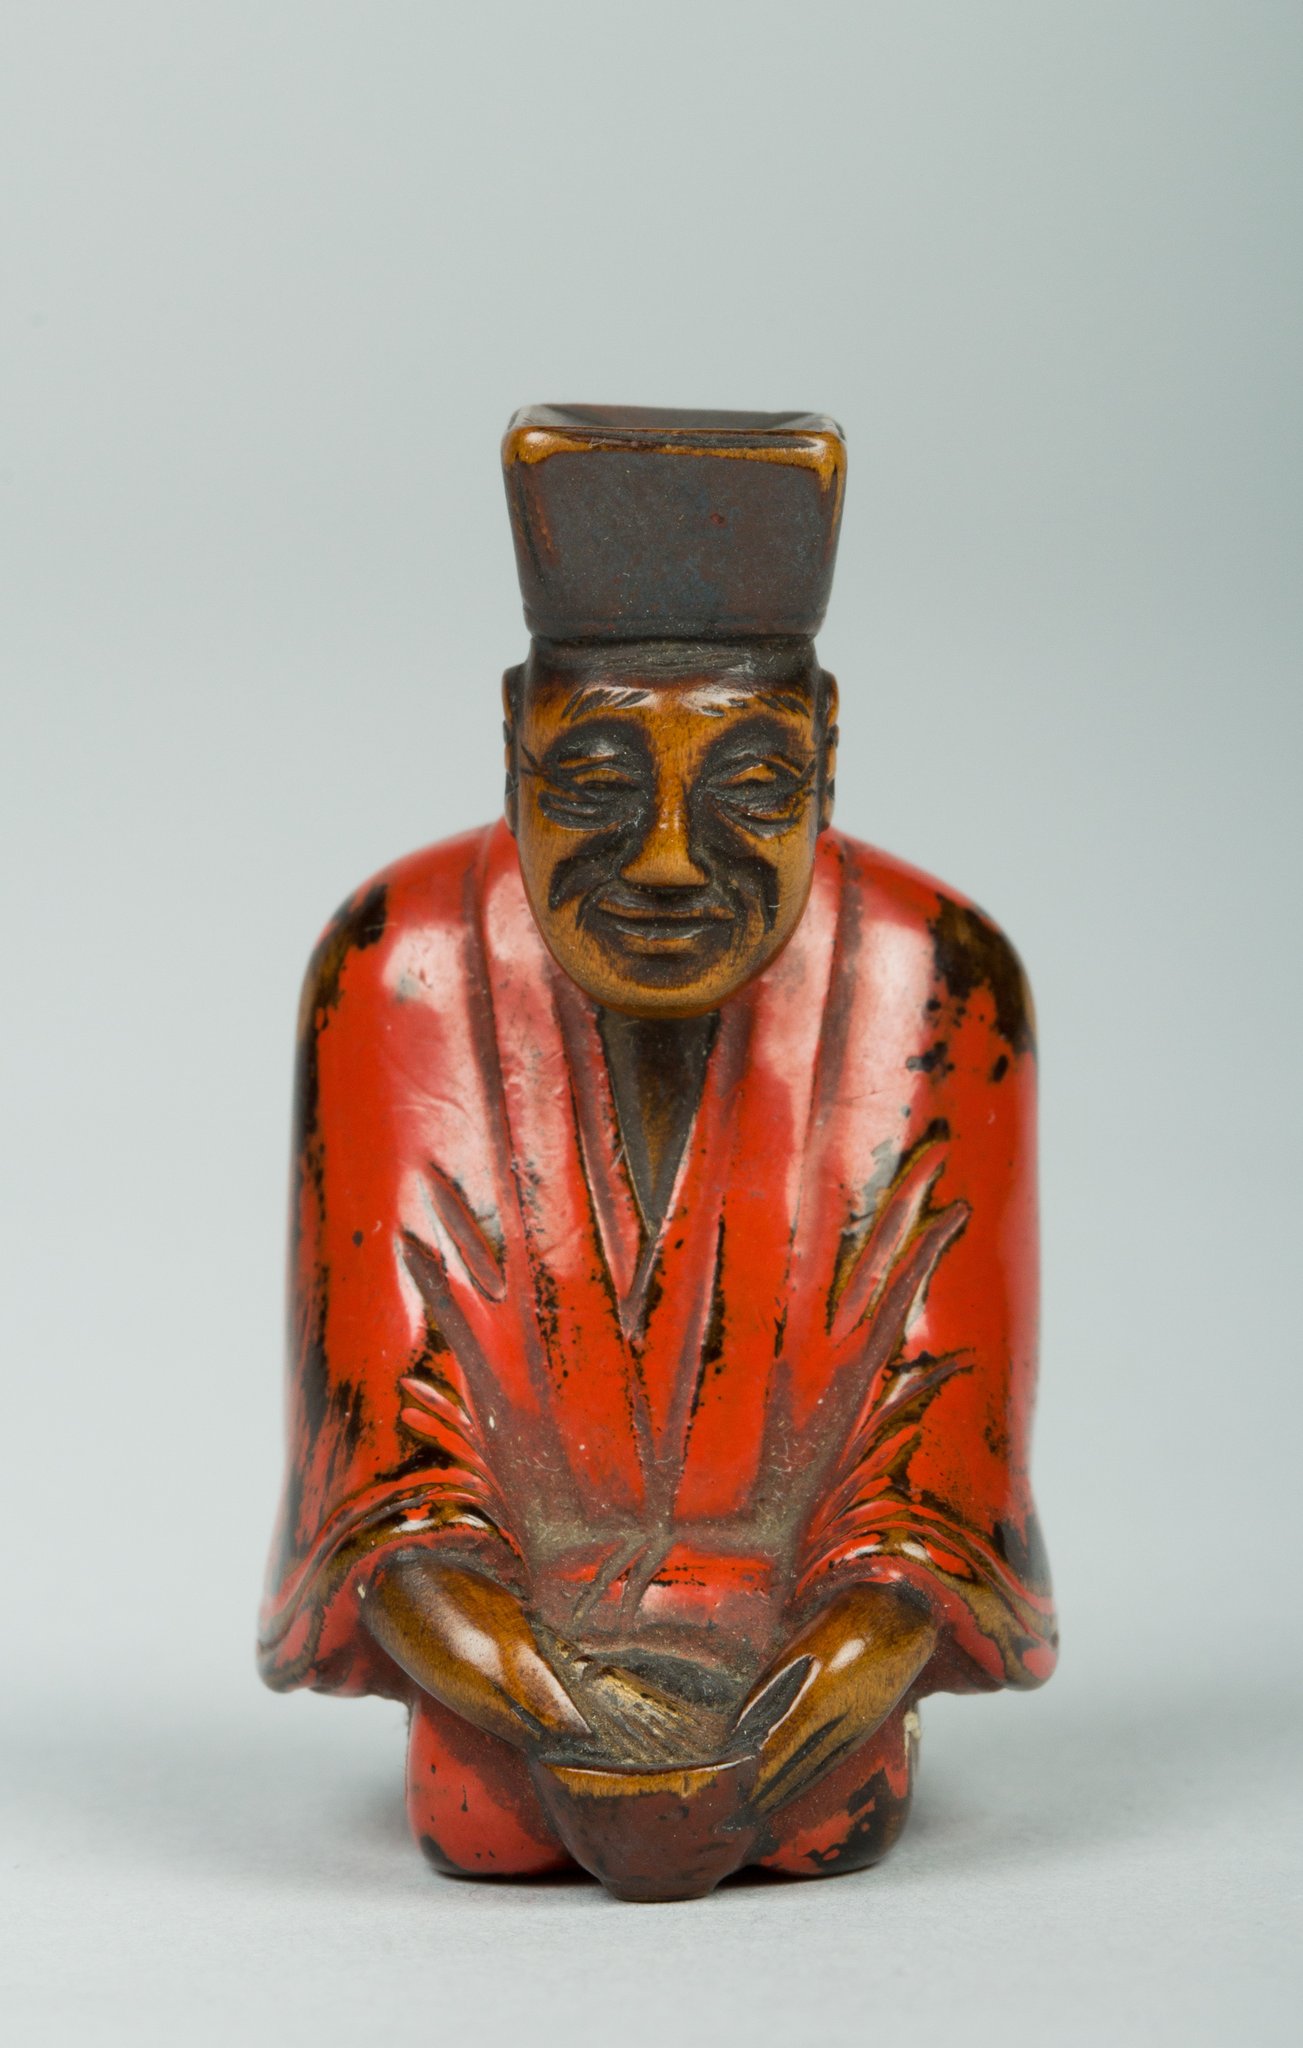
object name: netsuke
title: Netsuke of Tea Master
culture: japanese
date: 1701-1800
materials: lacquer, wood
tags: men